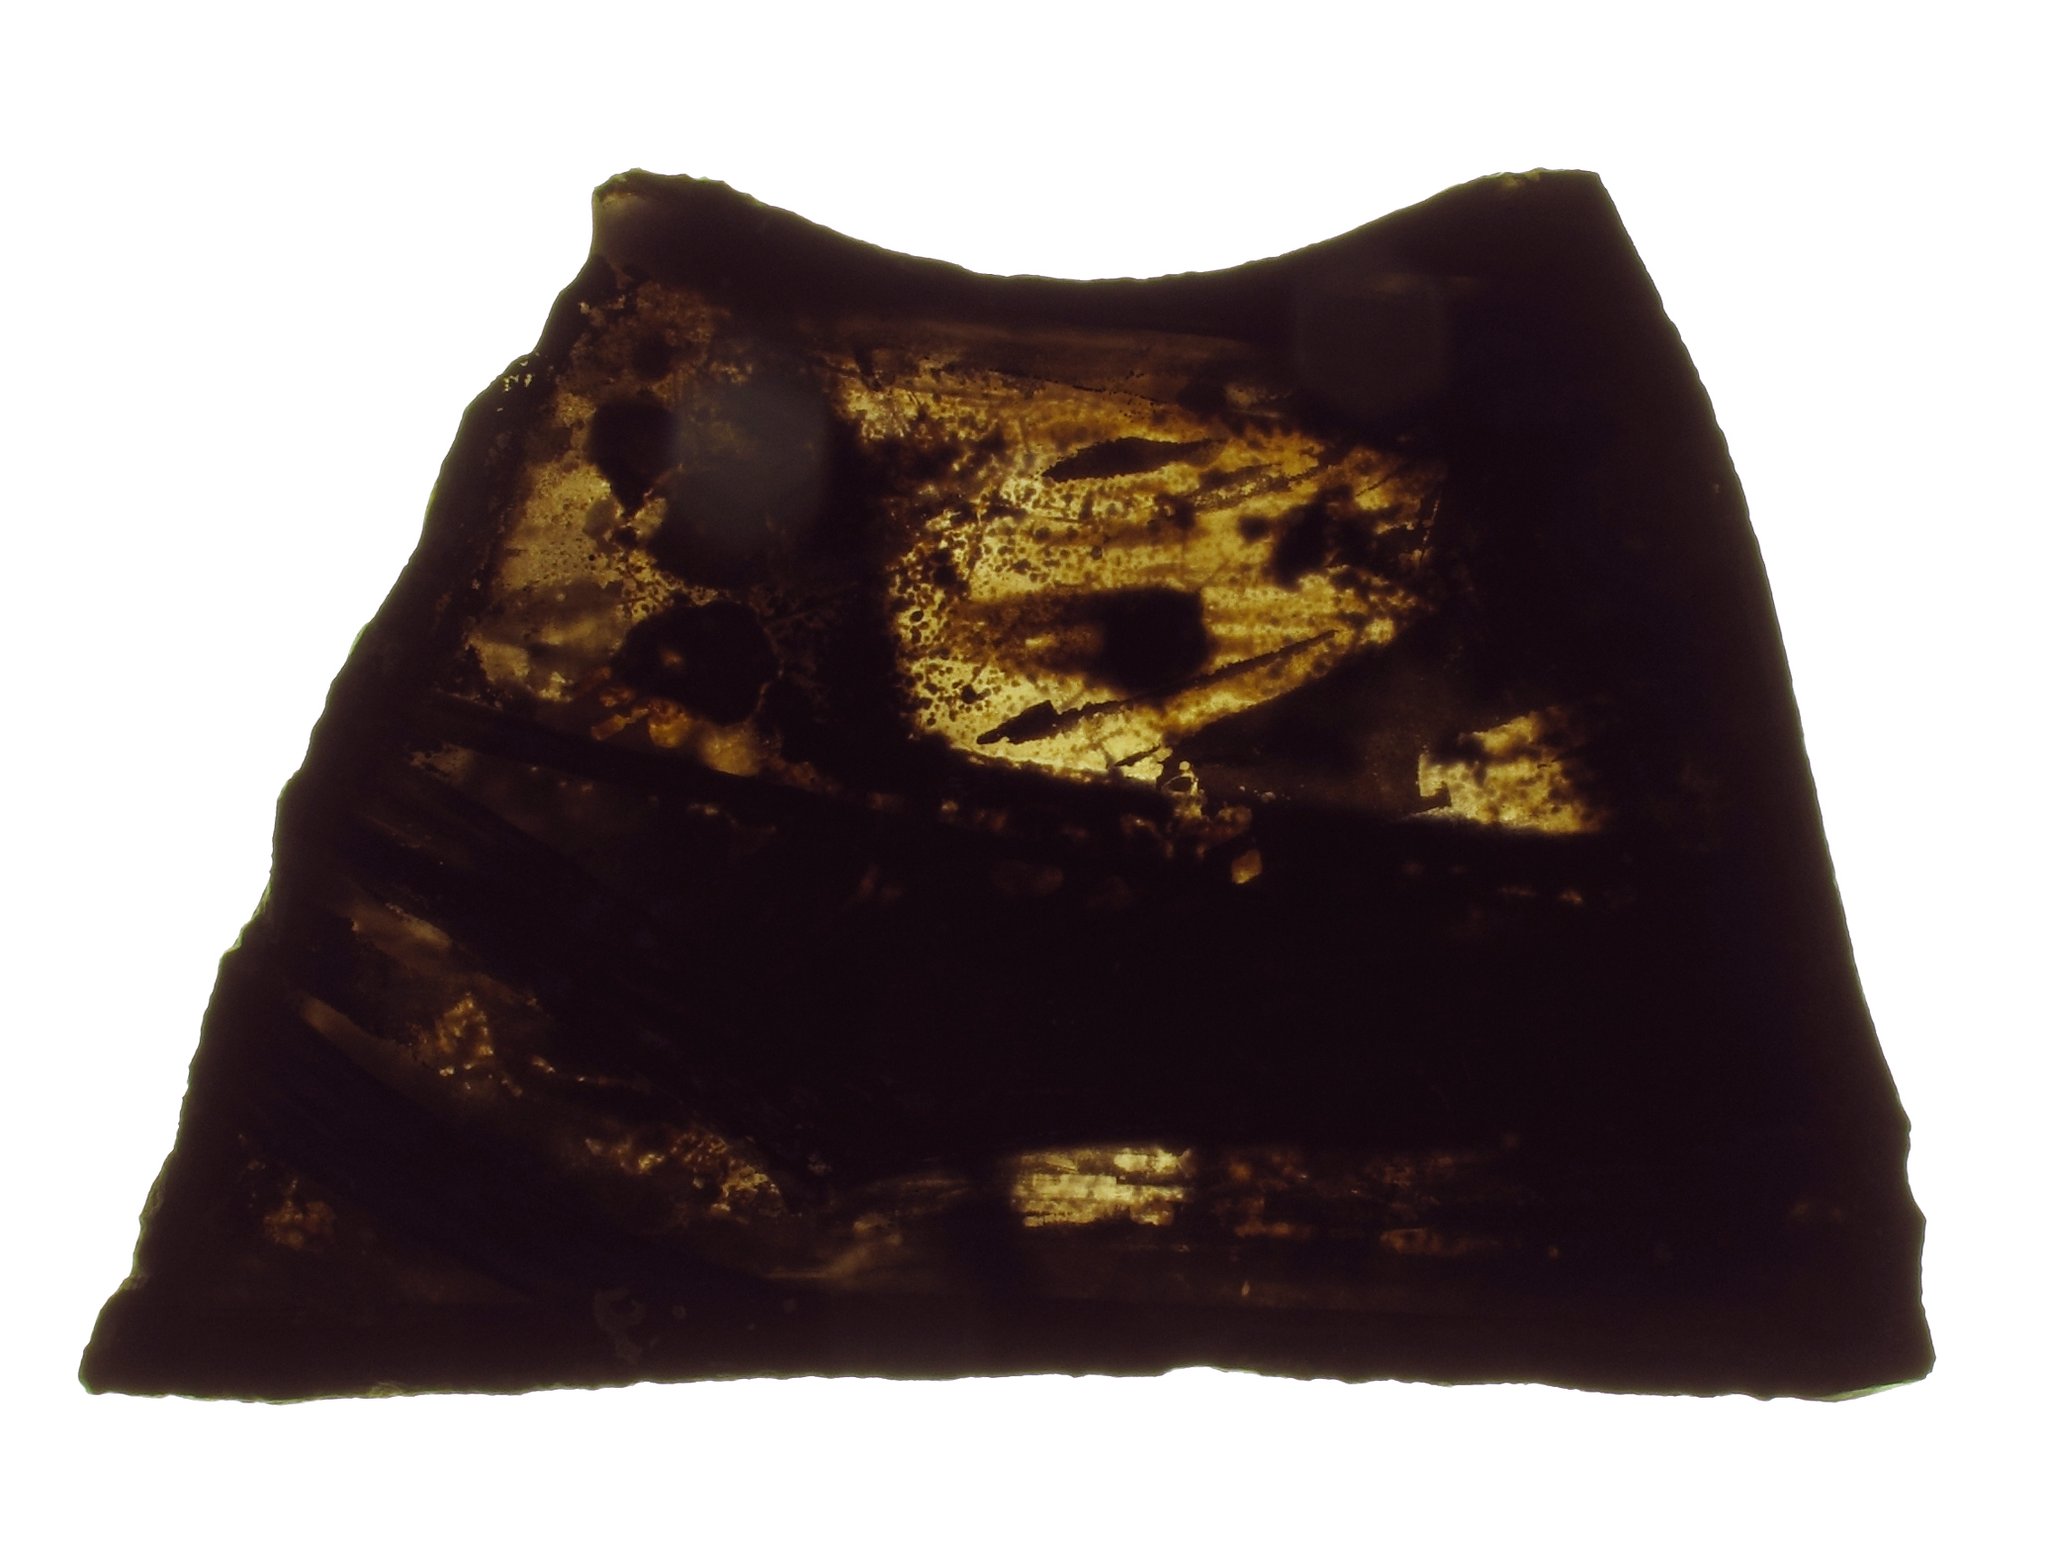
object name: fragment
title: Glass Fragment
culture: european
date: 1401-1500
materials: glass, metal